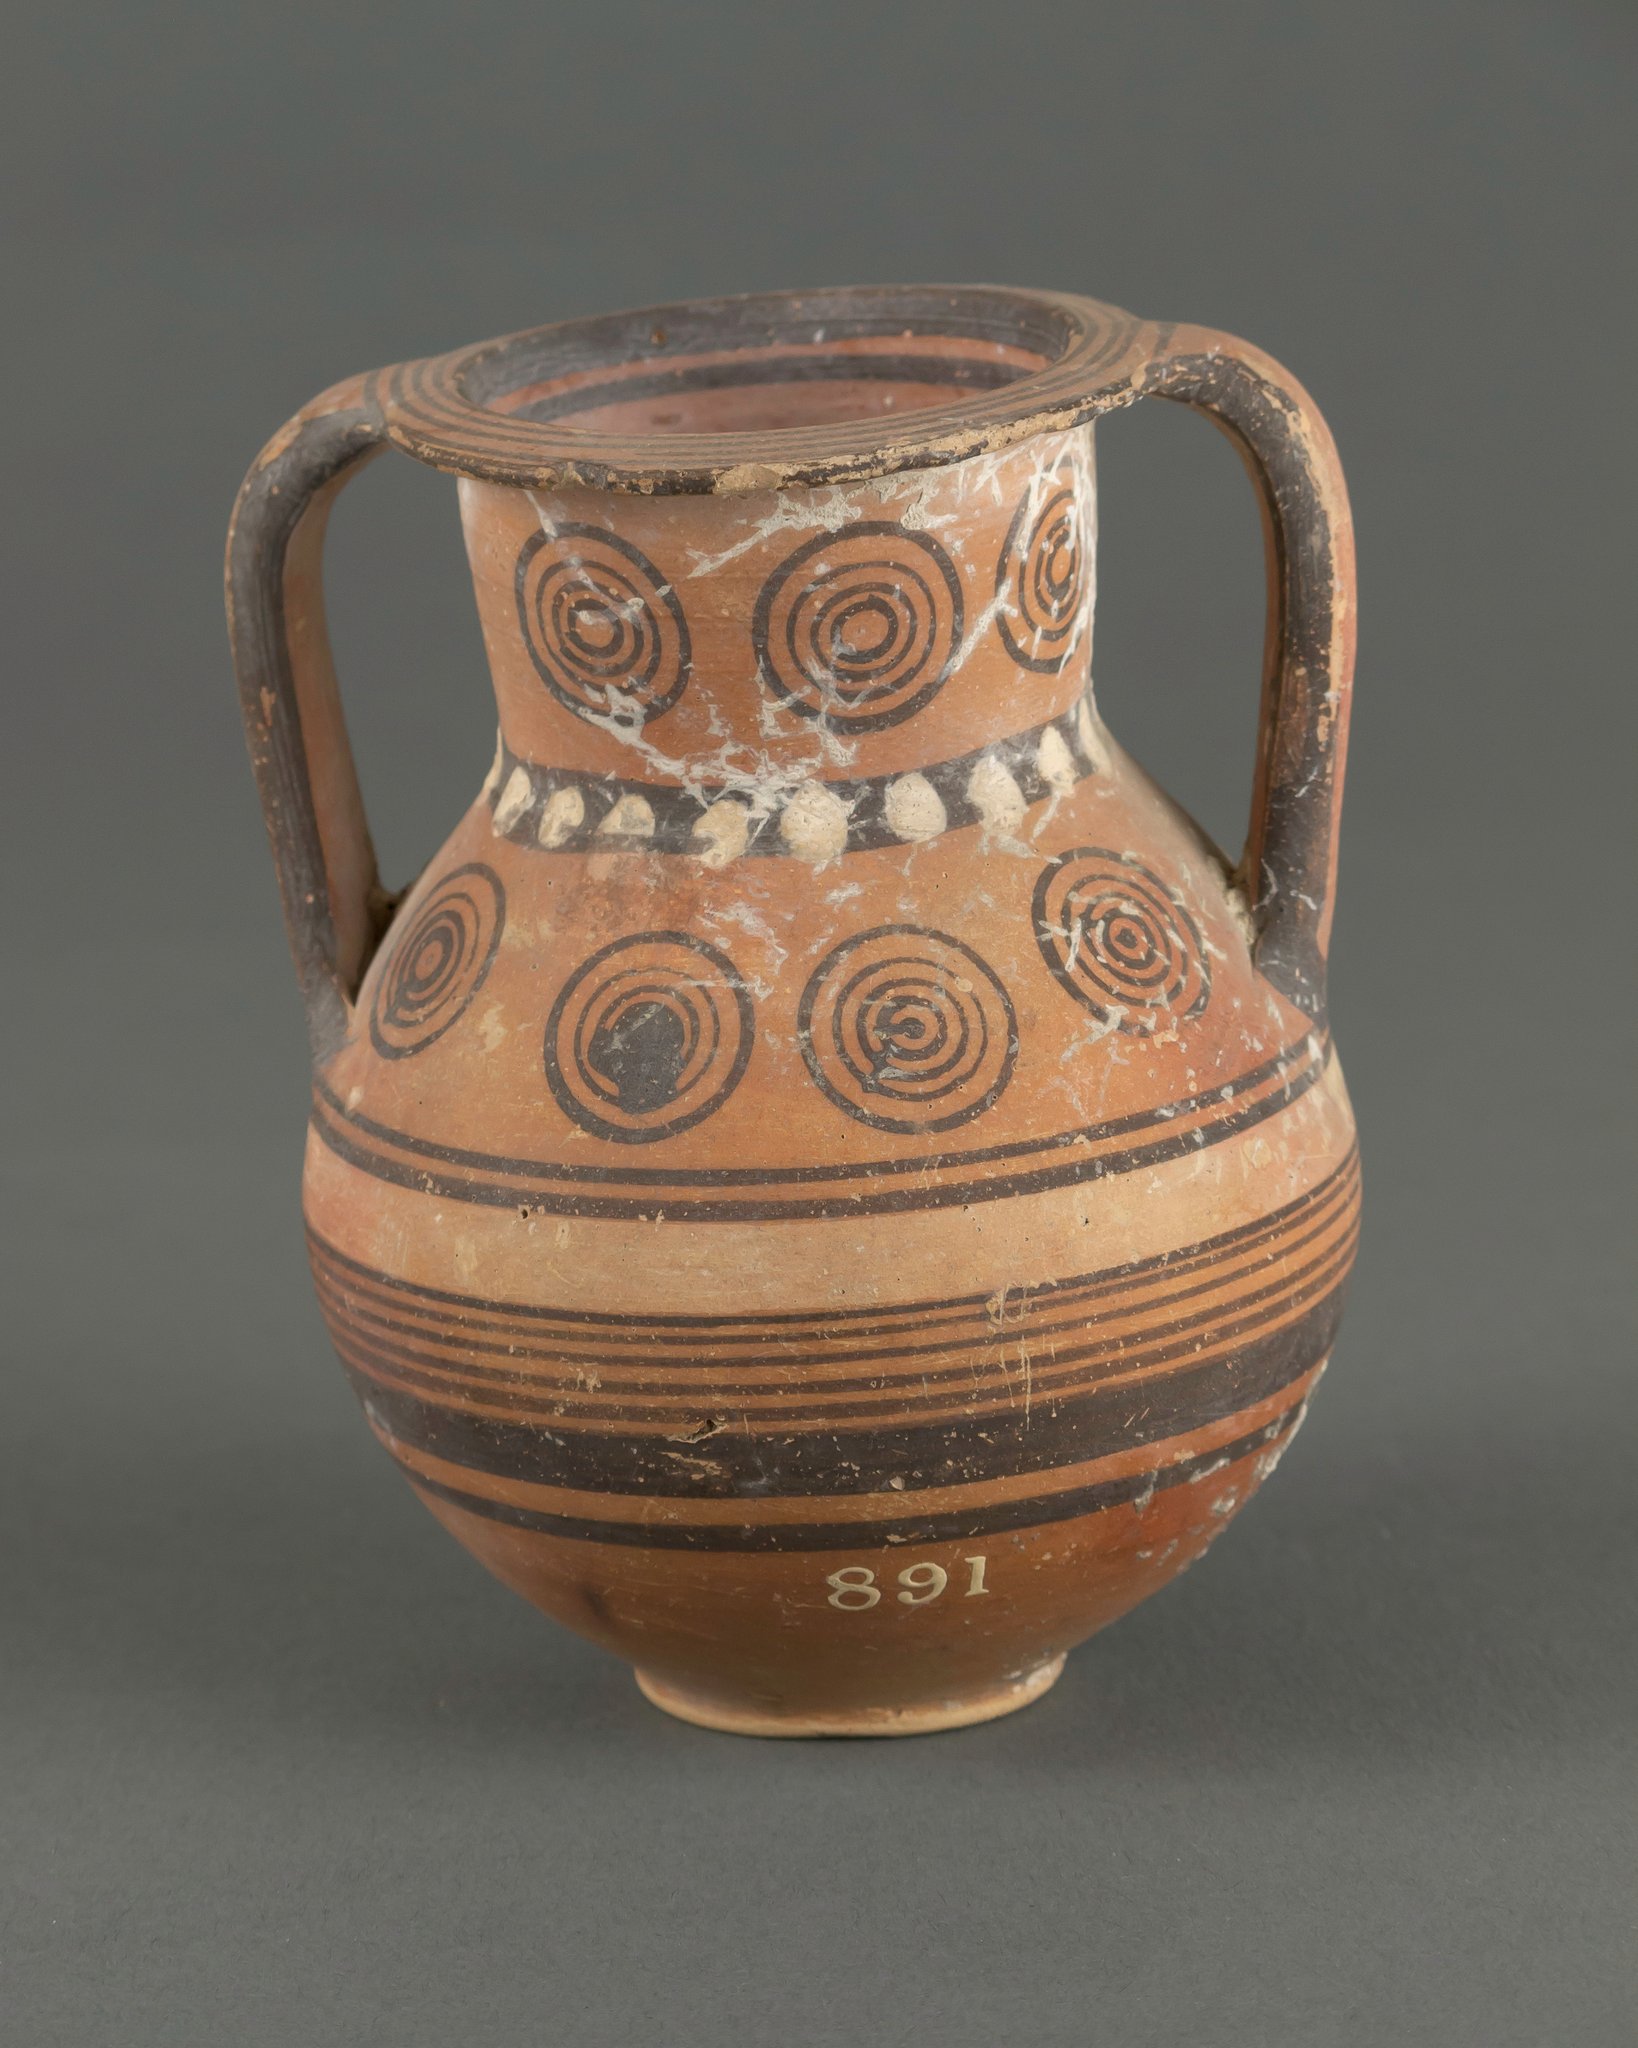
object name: amphoriskos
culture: cypriot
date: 750-600 BCE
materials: terracotta